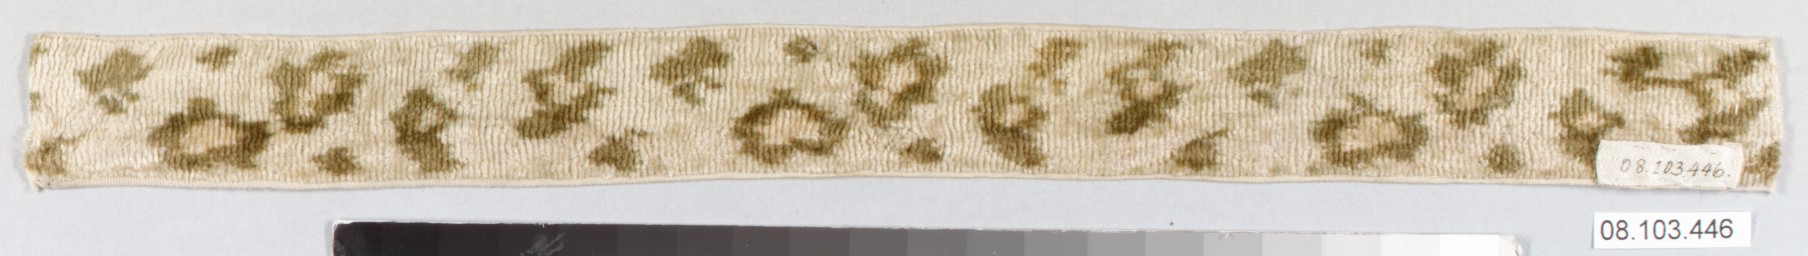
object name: galloon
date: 1801-1900